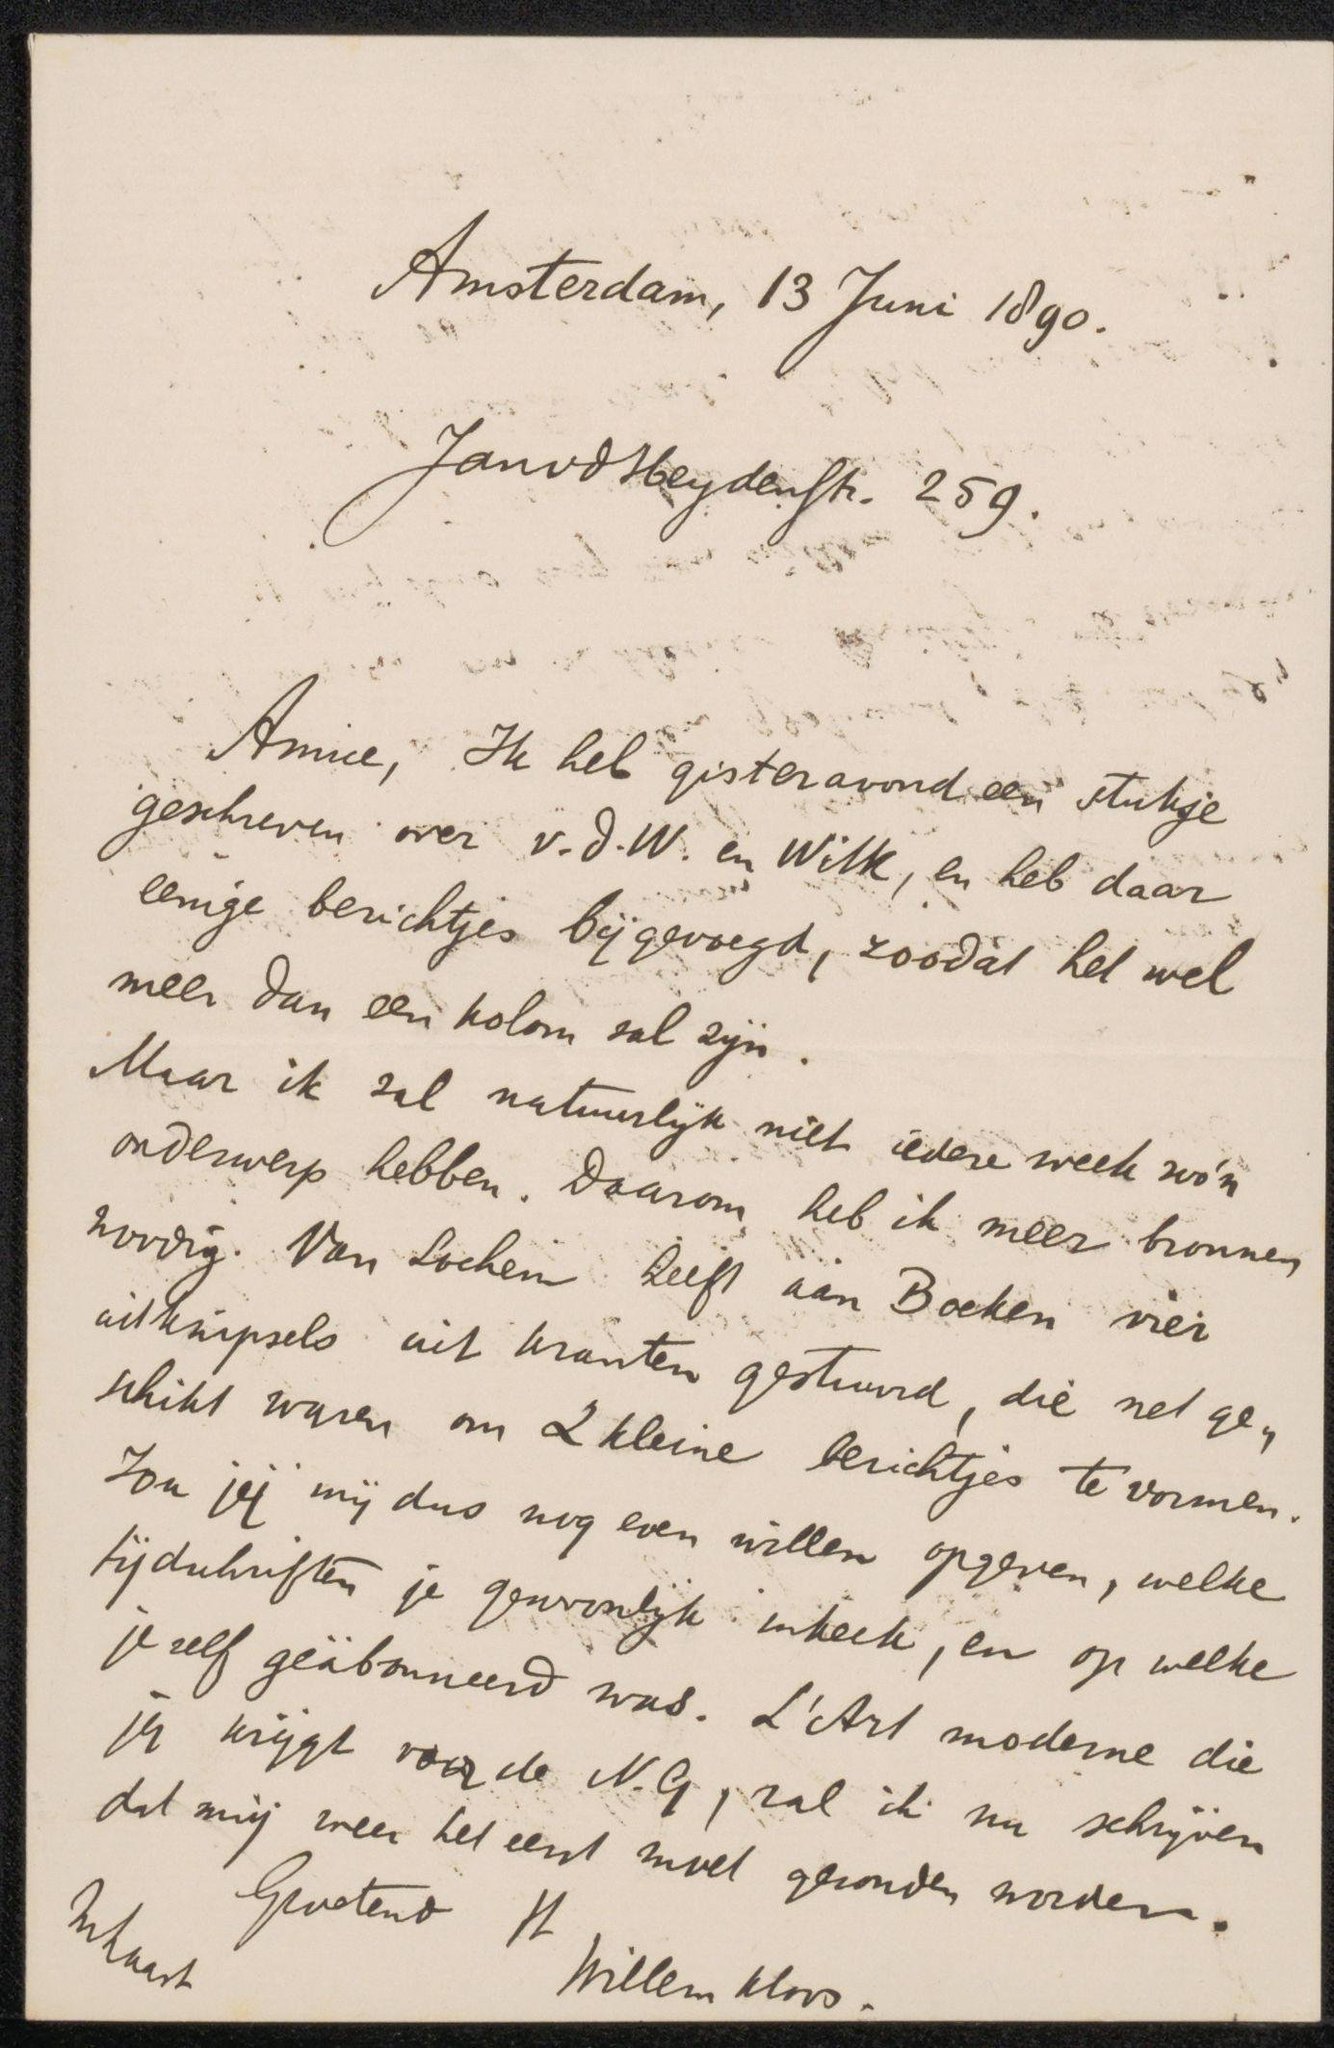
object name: letter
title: Brief aan Jan Veth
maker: willem kloos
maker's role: dichter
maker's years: 1859-1938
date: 1890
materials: ink, paper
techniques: pen, writing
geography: amsterdam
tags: dordrecht, amsterdam, painter, print maker, draughtsman, designer, jan veth, hein boeken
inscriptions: collector's mark: ‘RPK’, watermark